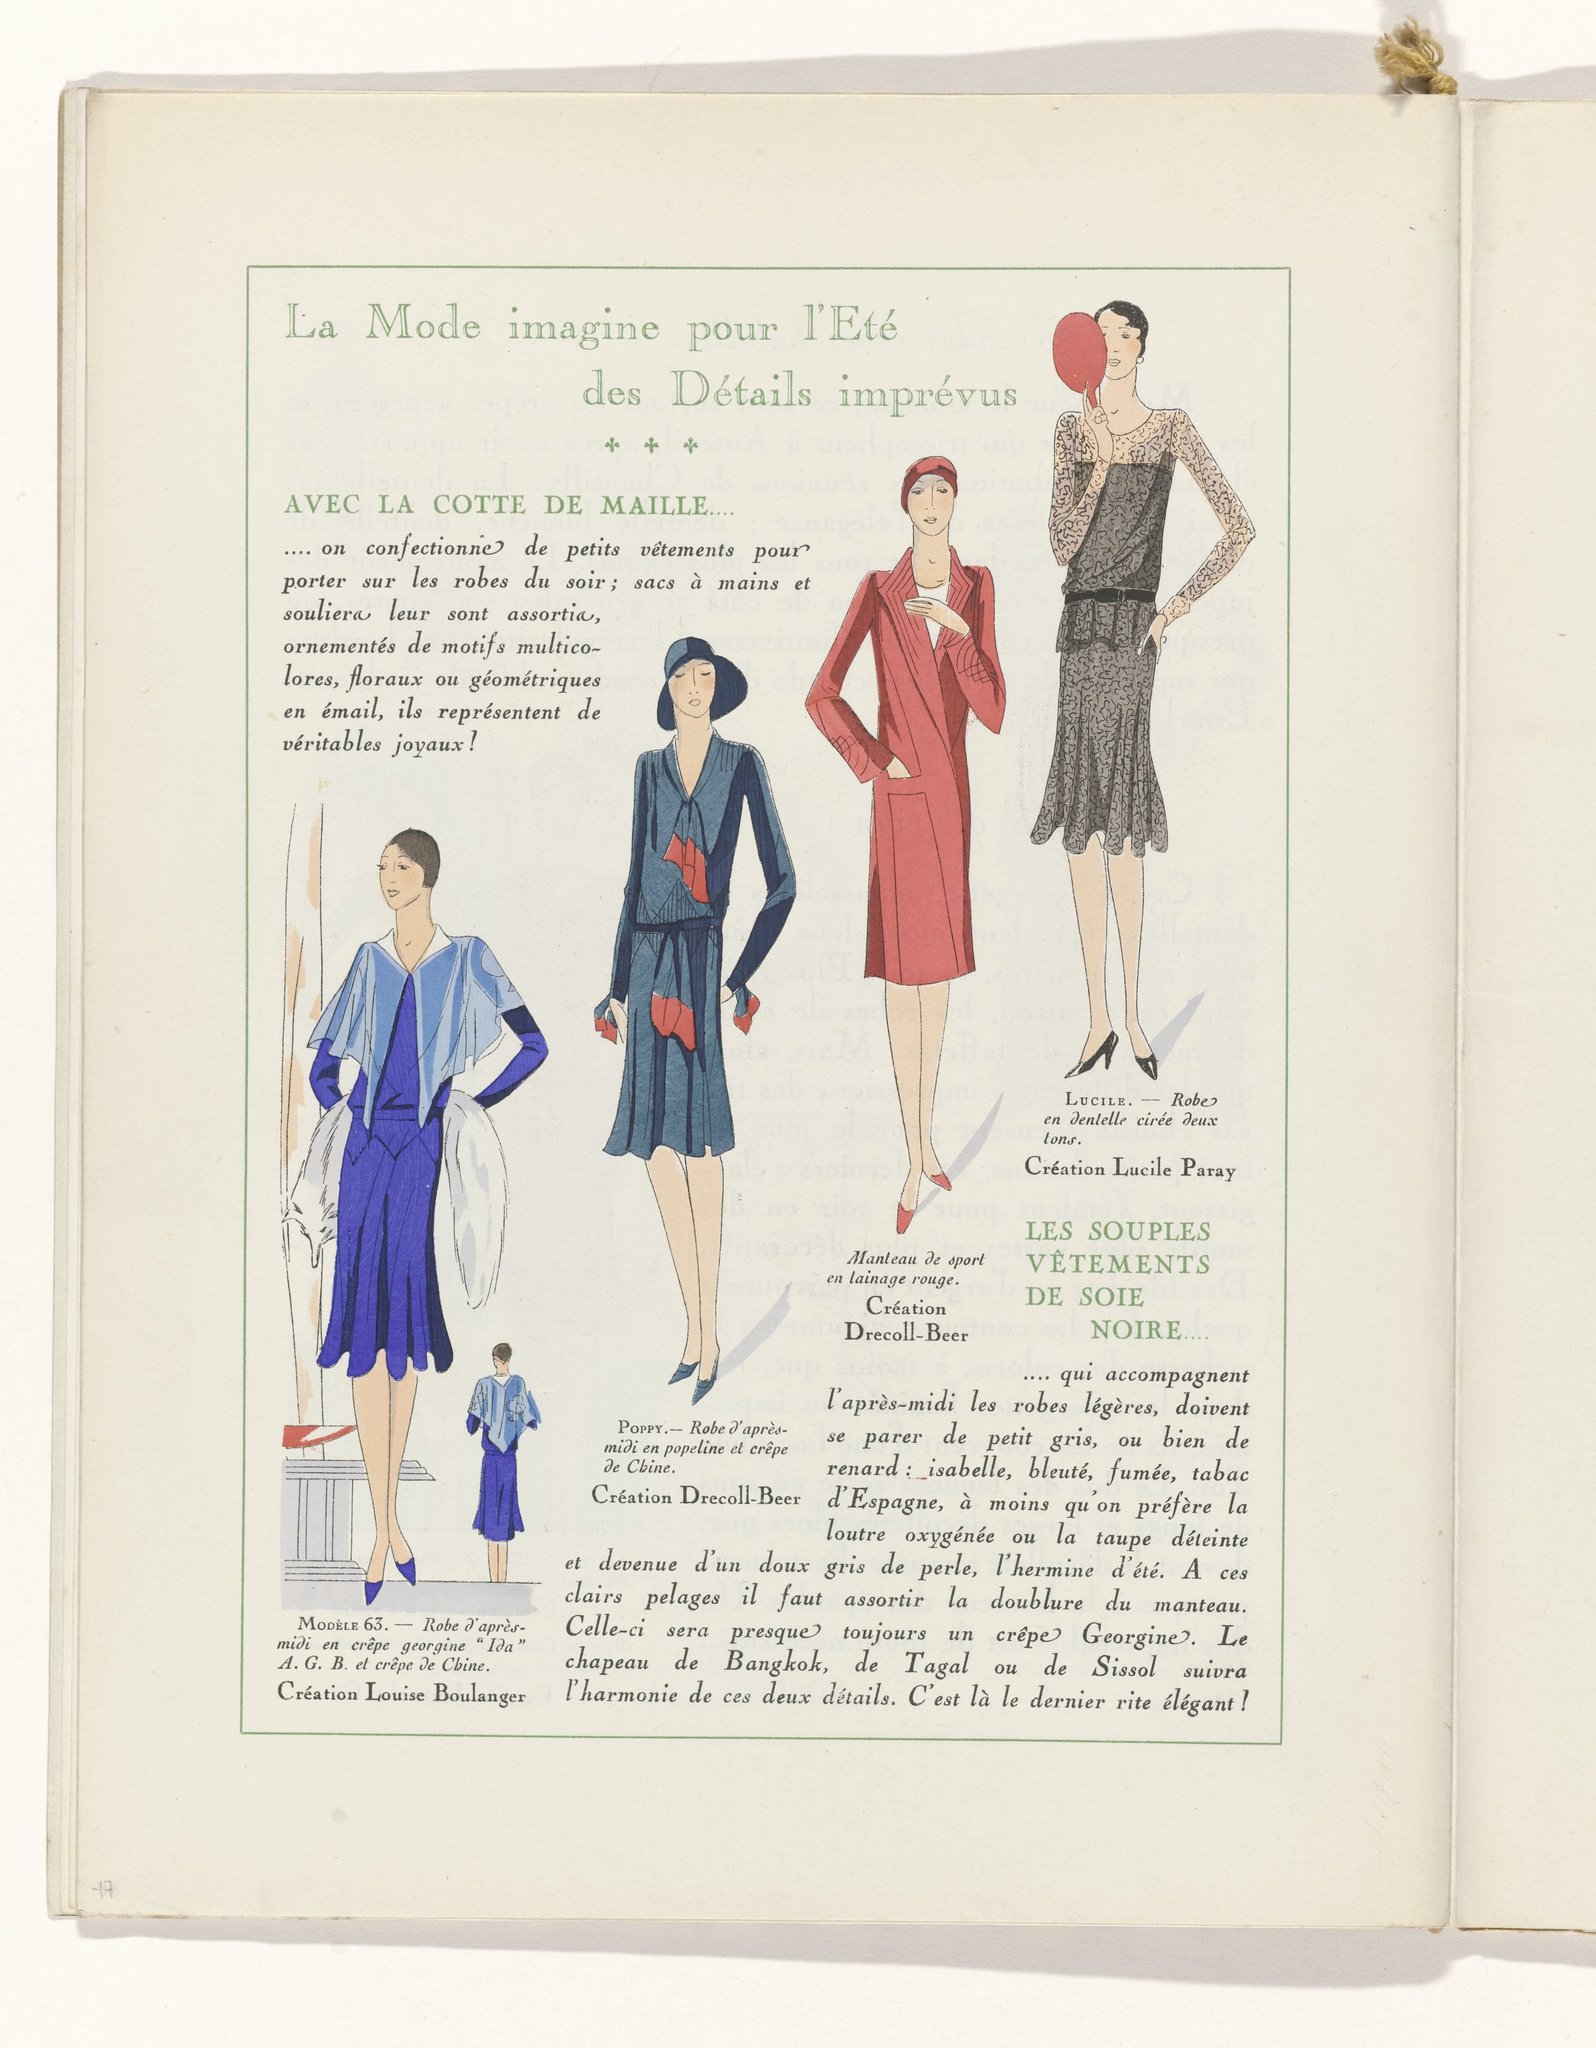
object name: fashion print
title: Art - Goût - Beauté, Feuillets de l' élégance féminine, Juin 1929, No. 106, 9e Année, p.17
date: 1929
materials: paper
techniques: hand coloring, lithograph, pochoir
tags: looking in the mirror; (possibly: contemplation of own beauty - aa - (for) women), lace (+ women's clothes), dress, gown: day dress (+ women's clothes), coat (+ women's clothes), fashion plates, head-gear: hat (+ women's clothes), clothing for the upper part of the body (shawl) (+ fur used for clothes)